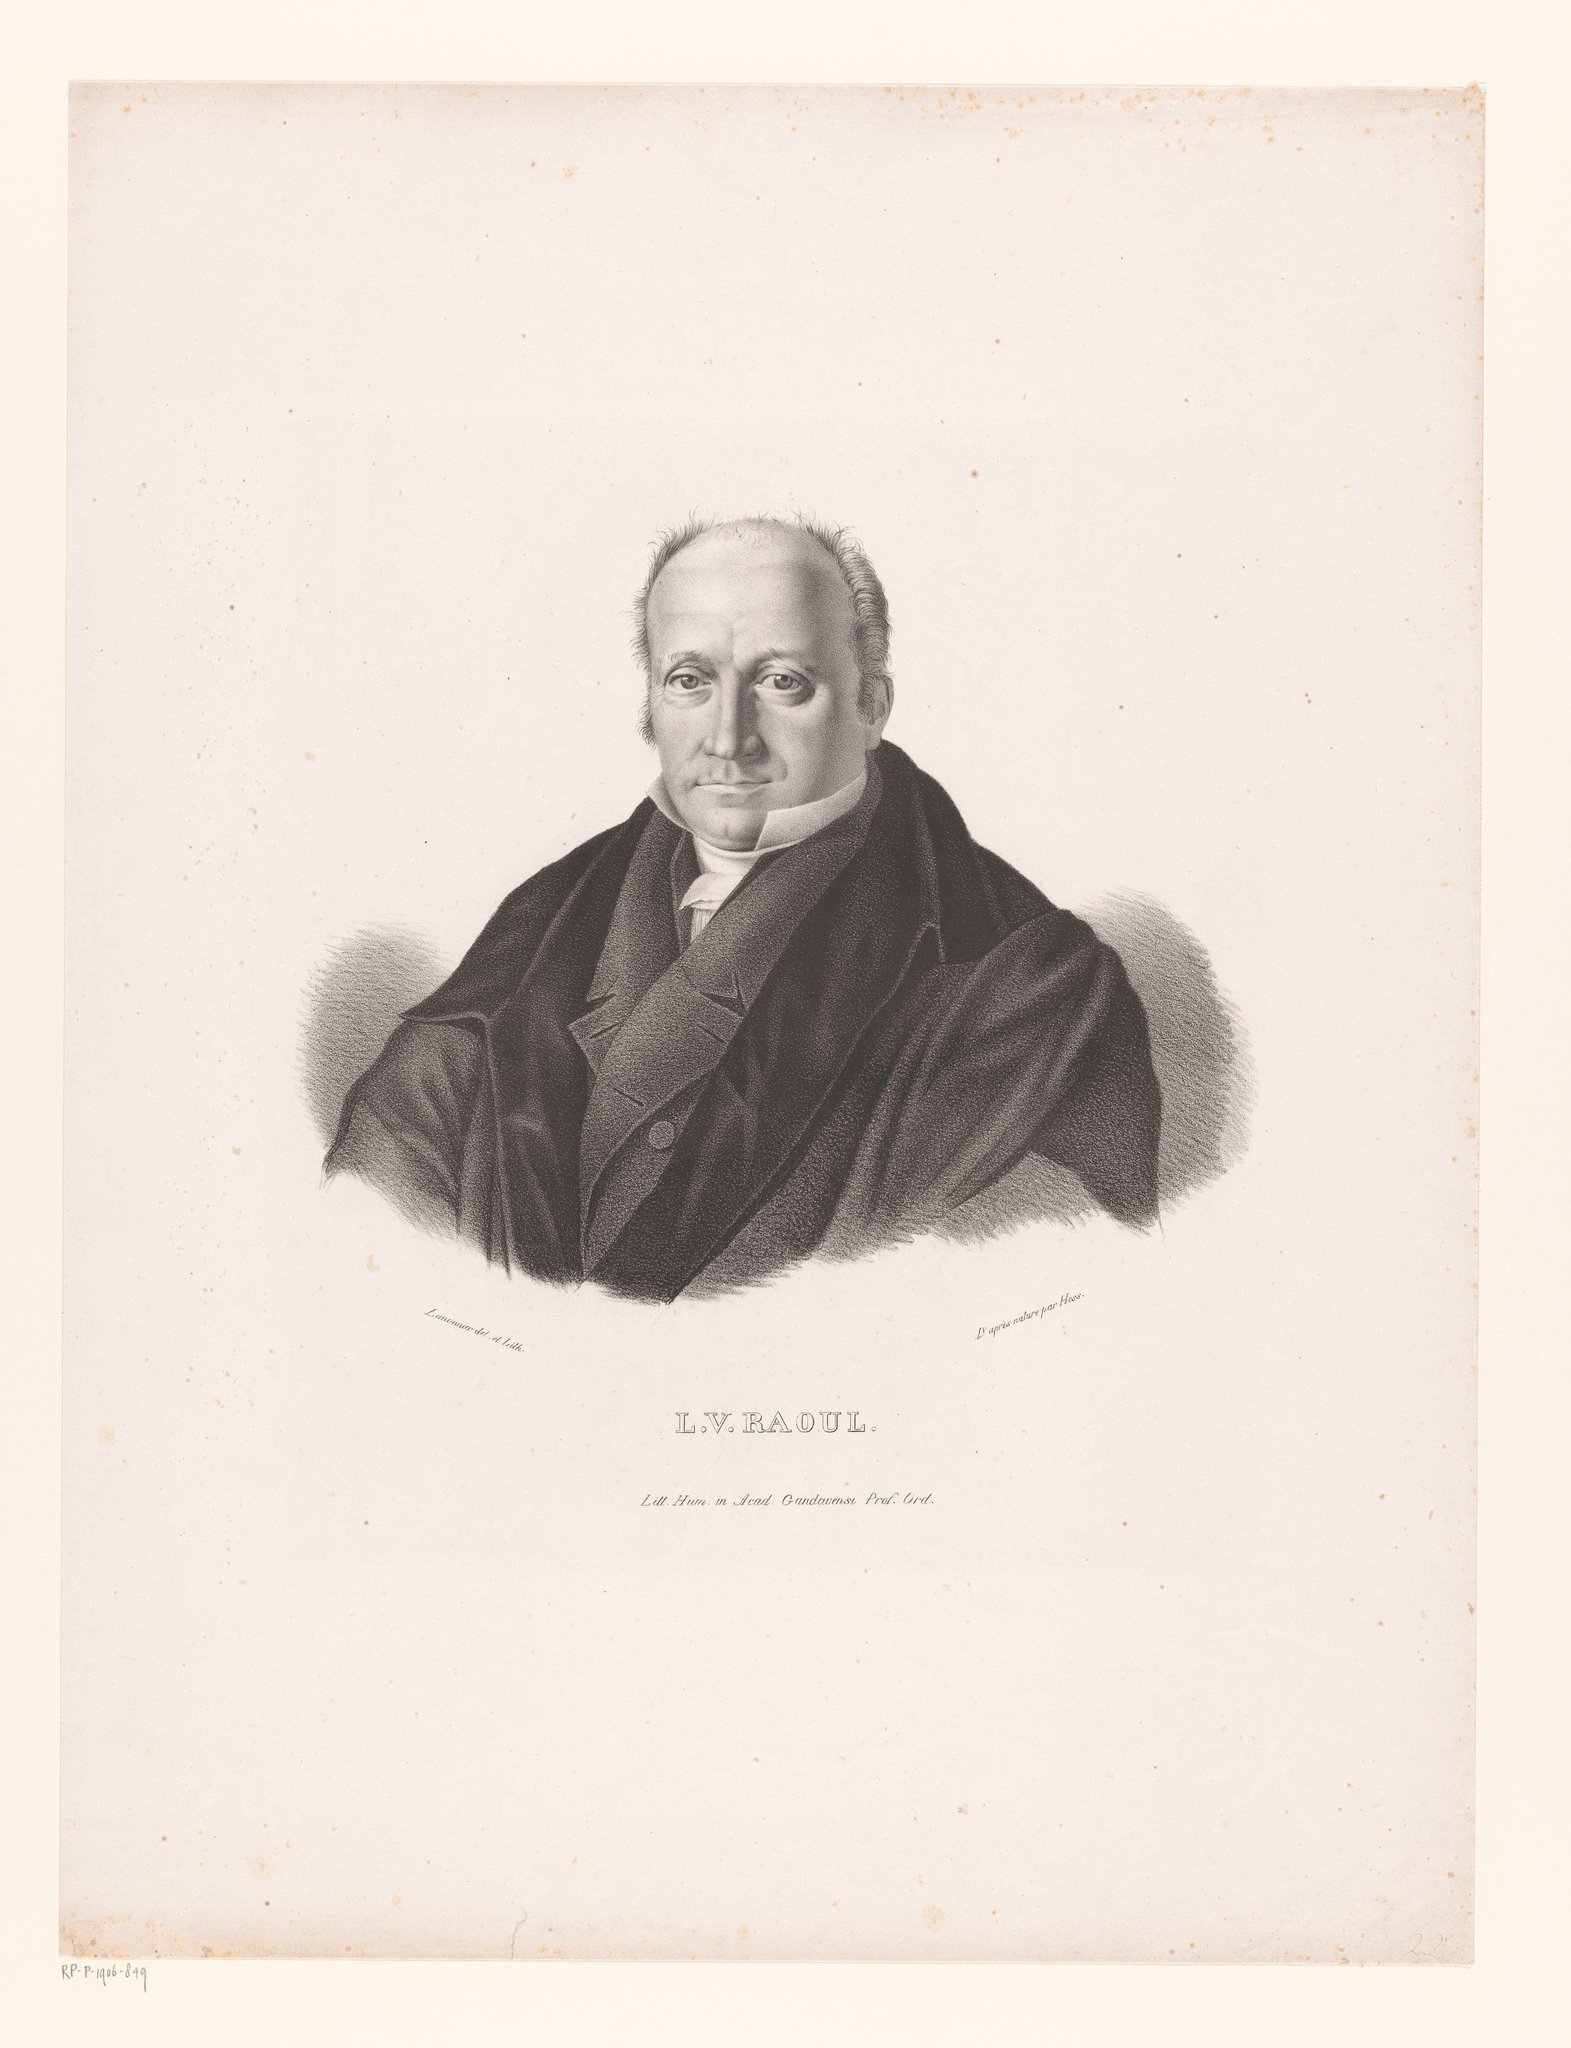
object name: print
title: Portret van Louis Vincent Raoul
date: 1827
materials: paper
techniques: lithograph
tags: brussels, historical persons, professor (+ portrait of teacher, professor)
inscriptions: collector's mark: Lugt 2228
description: Prent verschenen in: Hess, Marcel. Iconographie des professeurs des universites des Pays-Bas. Brussel: Van Someren, 1827.